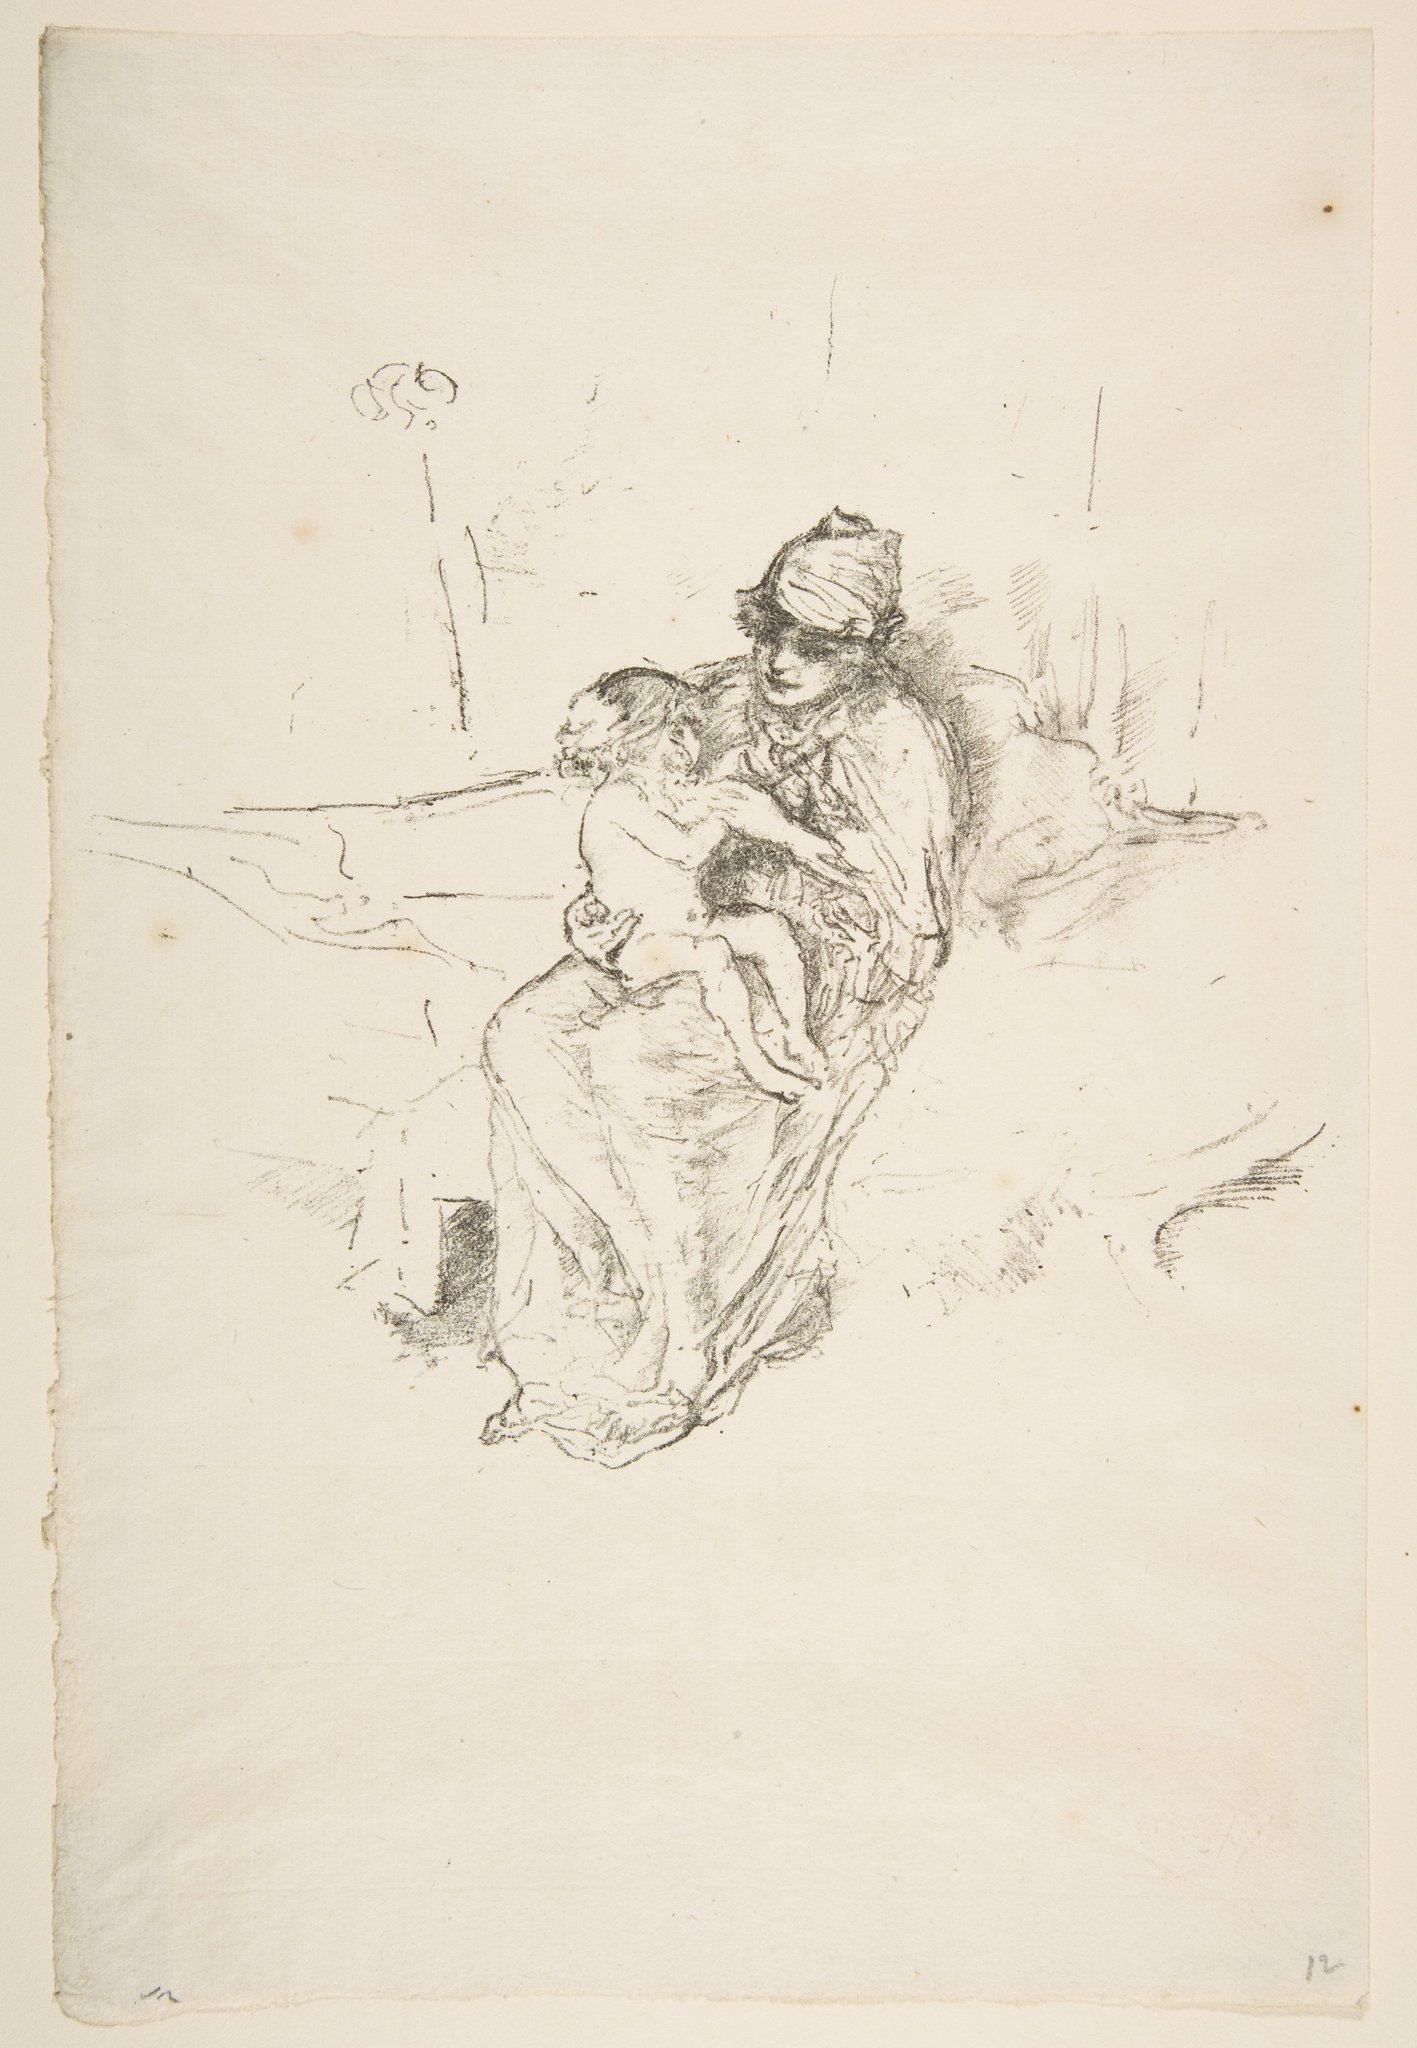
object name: print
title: Mother and Child, No. 1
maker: james mcneill whistler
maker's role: artist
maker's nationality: american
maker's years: 1834-1903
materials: ink, paper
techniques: printing, scraping, stumping, lithography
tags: infants,mothers